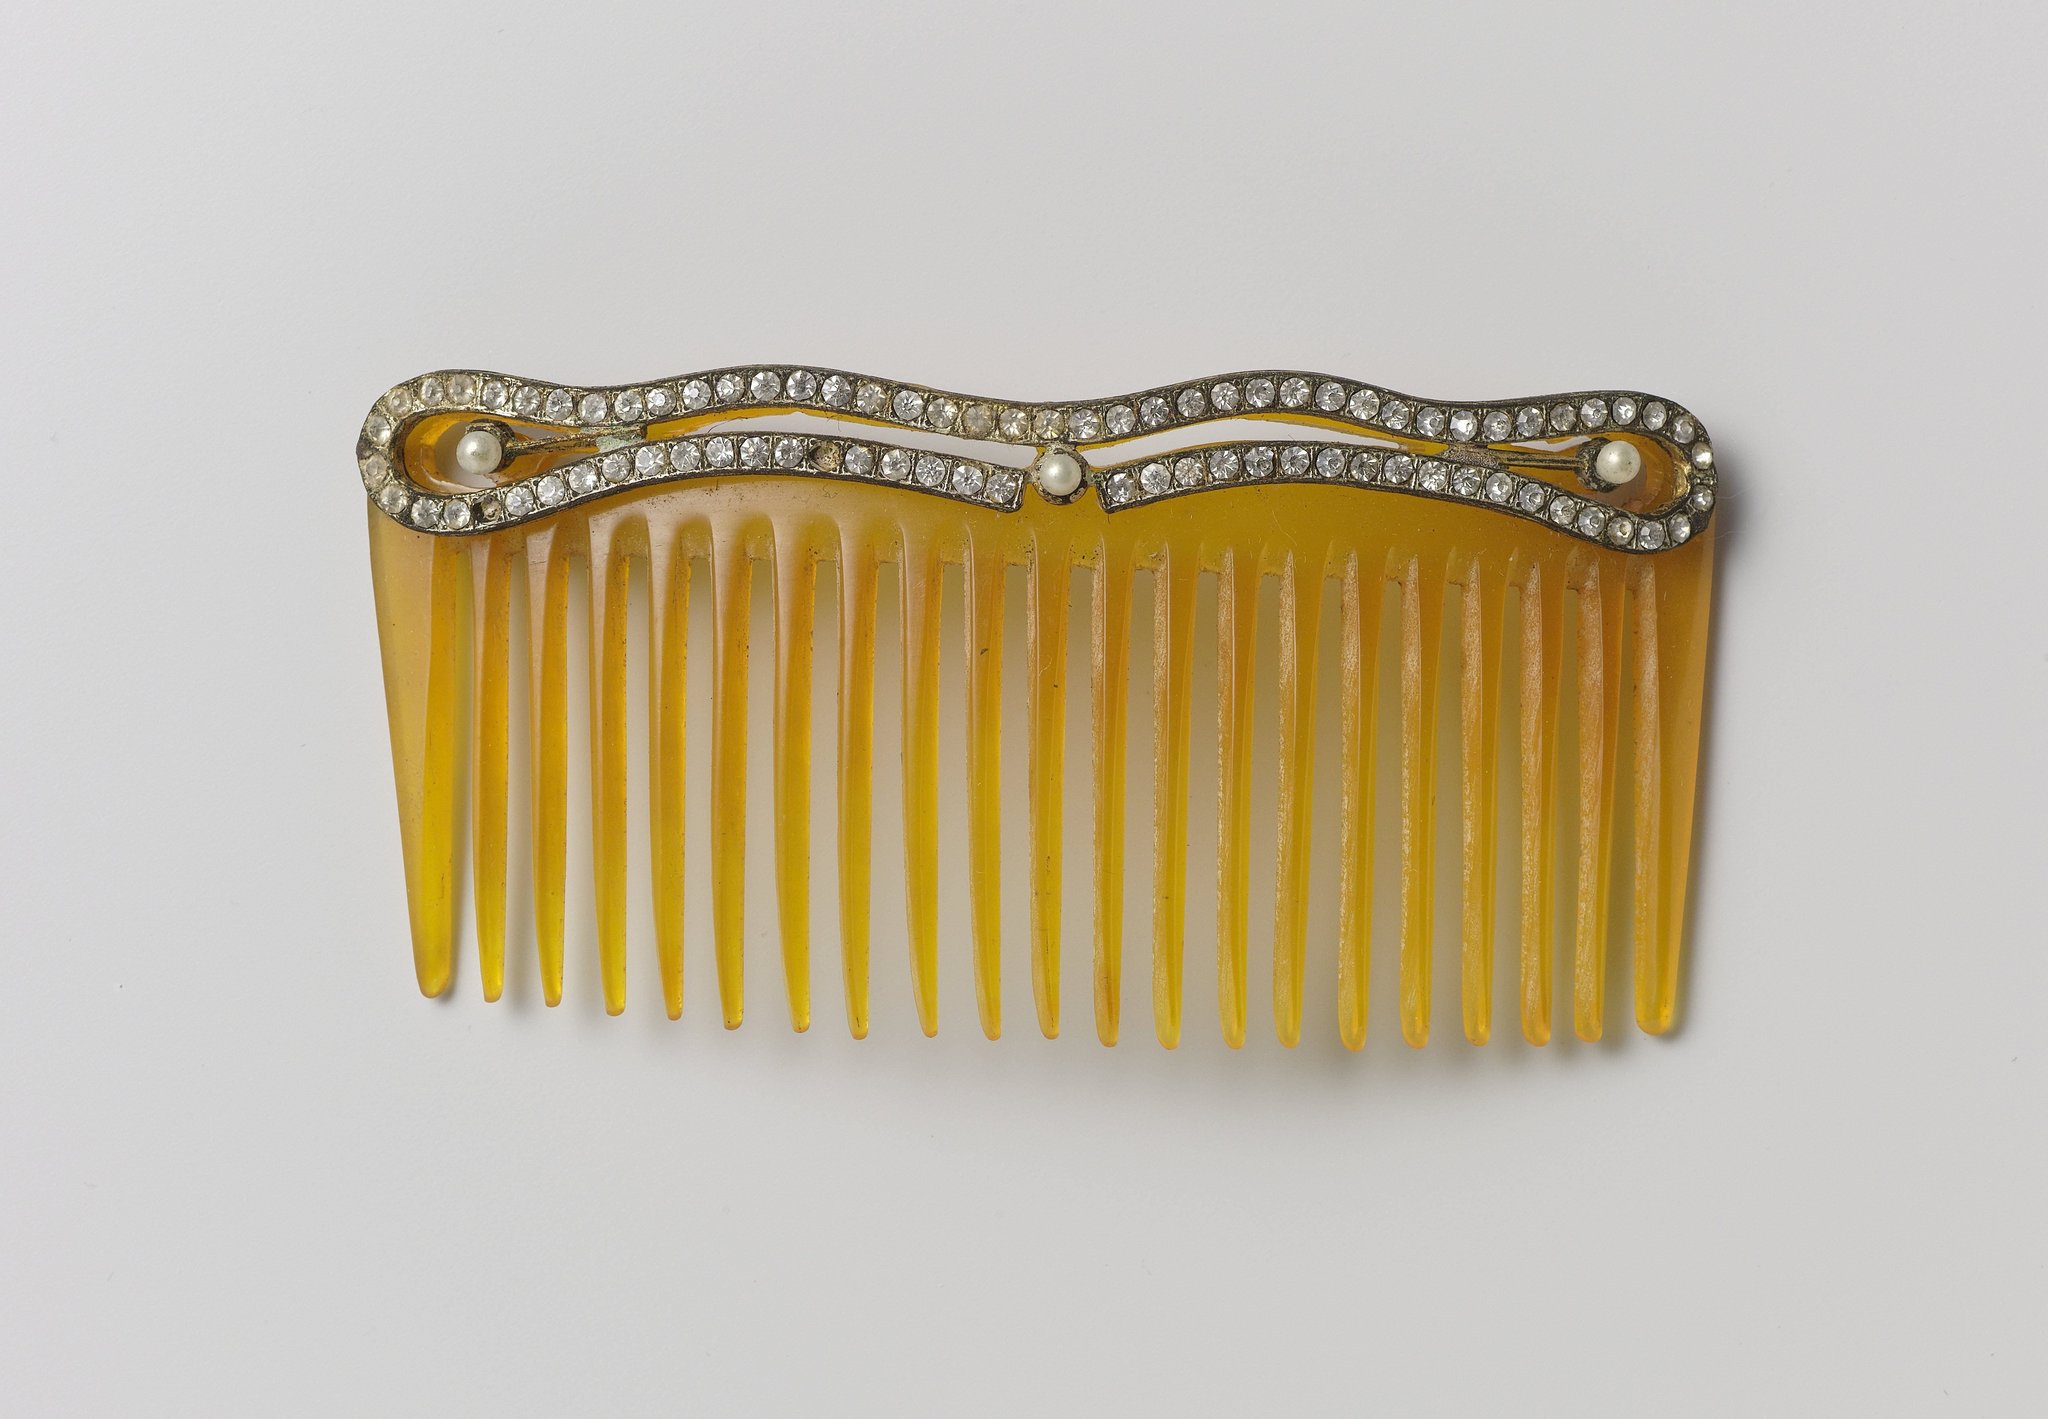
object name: comb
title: Haarkam van kunststof, met rug waarop parels en stras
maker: Anonymous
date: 1875-1900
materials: celluloid, plastic, copper, paste, pearl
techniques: filing, inlay, polish, pressing, sawing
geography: netherlands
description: Haarkam van oranjegele kunststof, met sierlijke rug, gezet met drie parels en stras in metaal. Eenentwintig tanden.